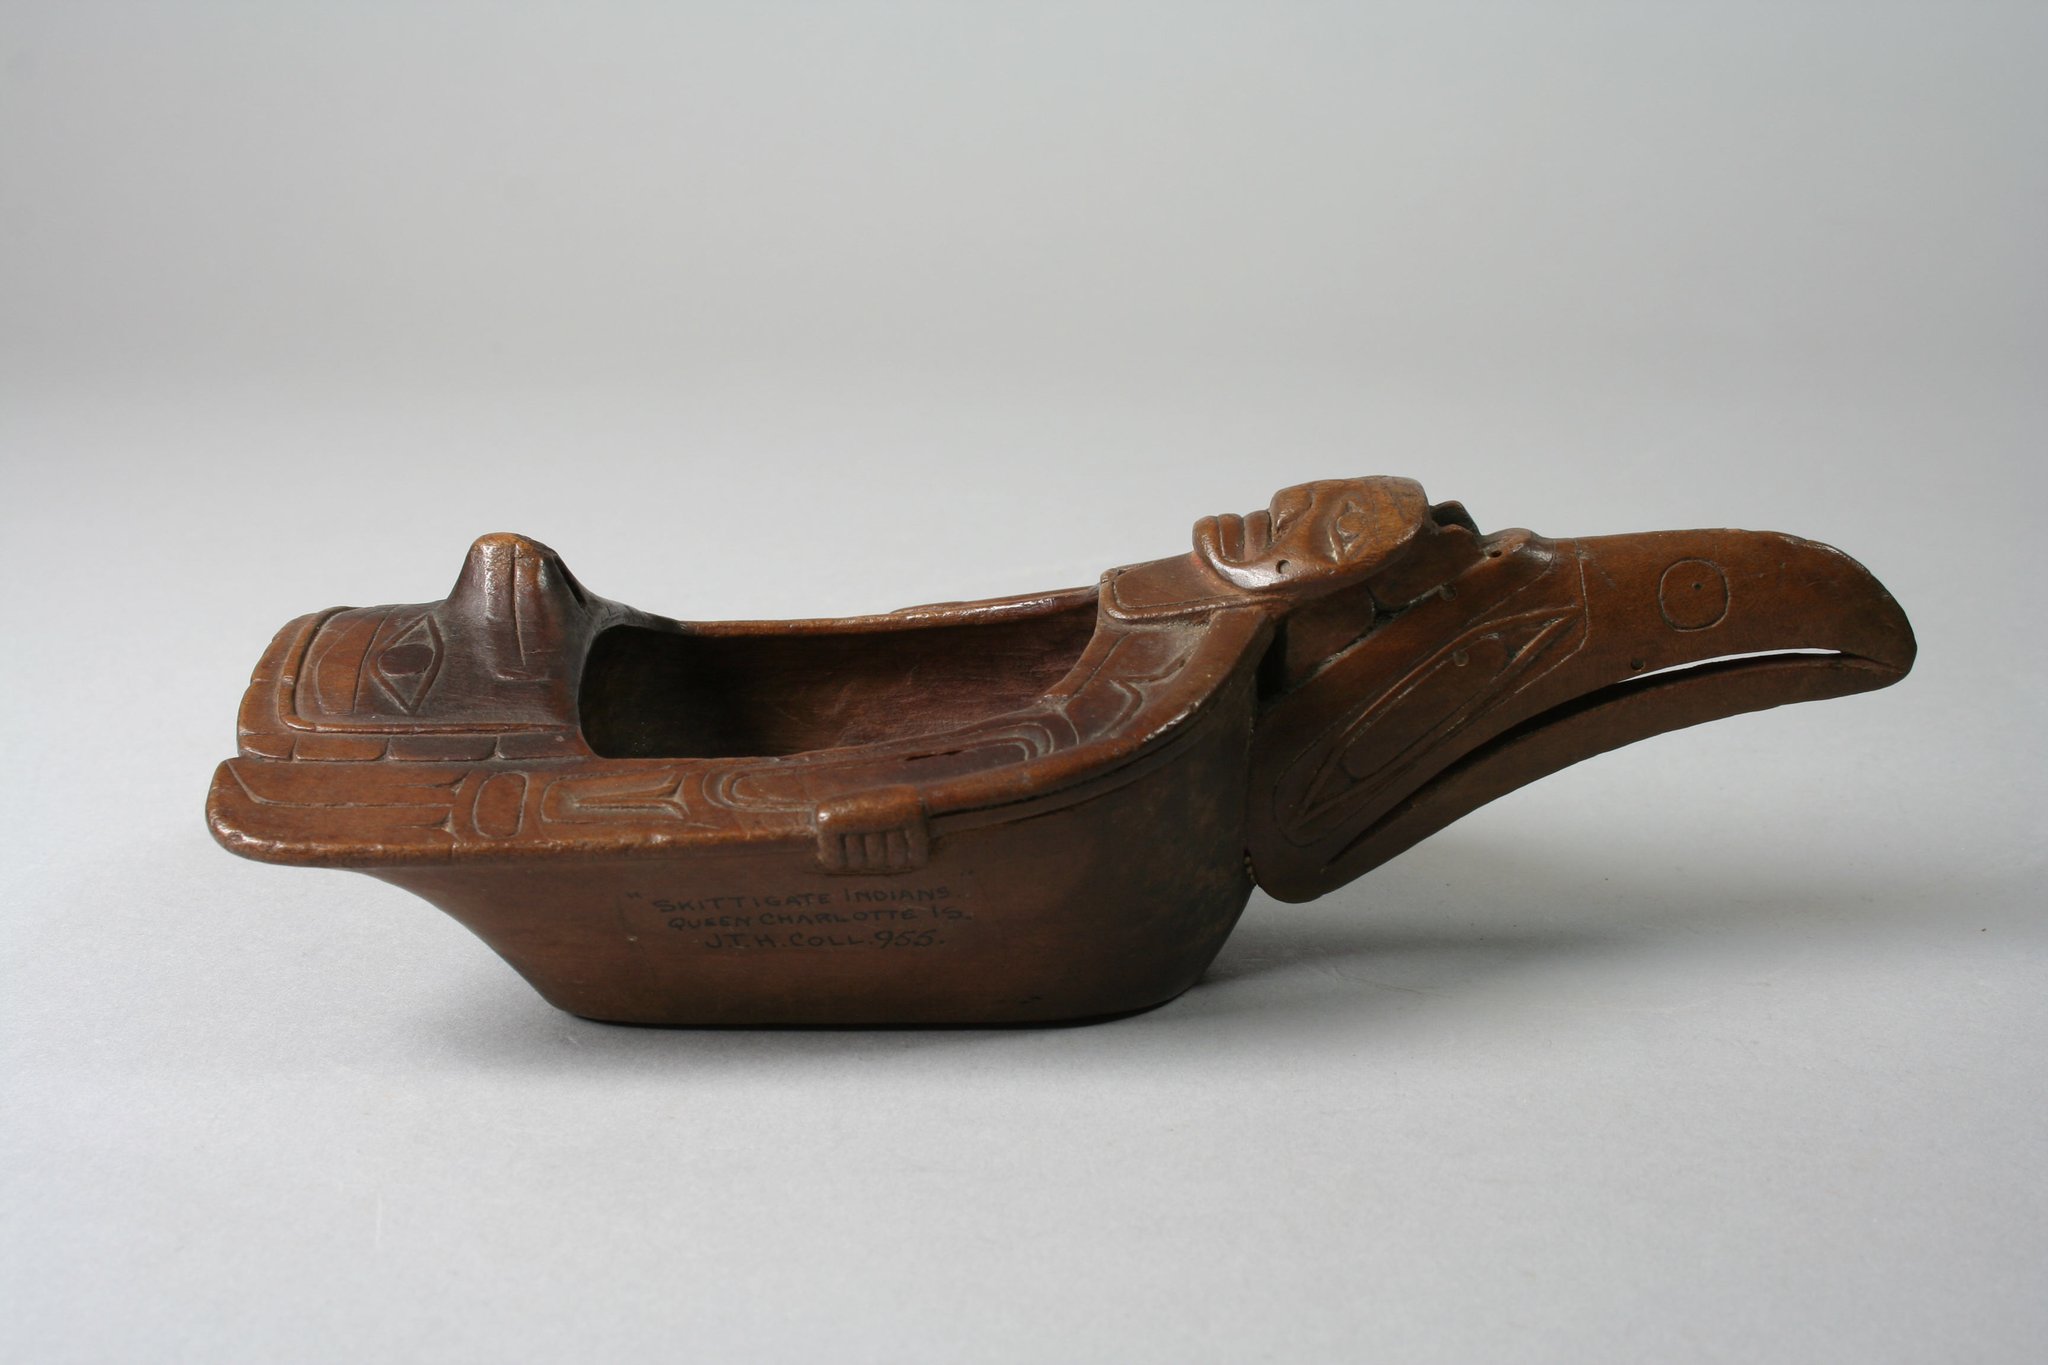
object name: bowl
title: Raven Bowl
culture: haida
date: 1870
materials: paint, wood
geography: canada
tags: faces